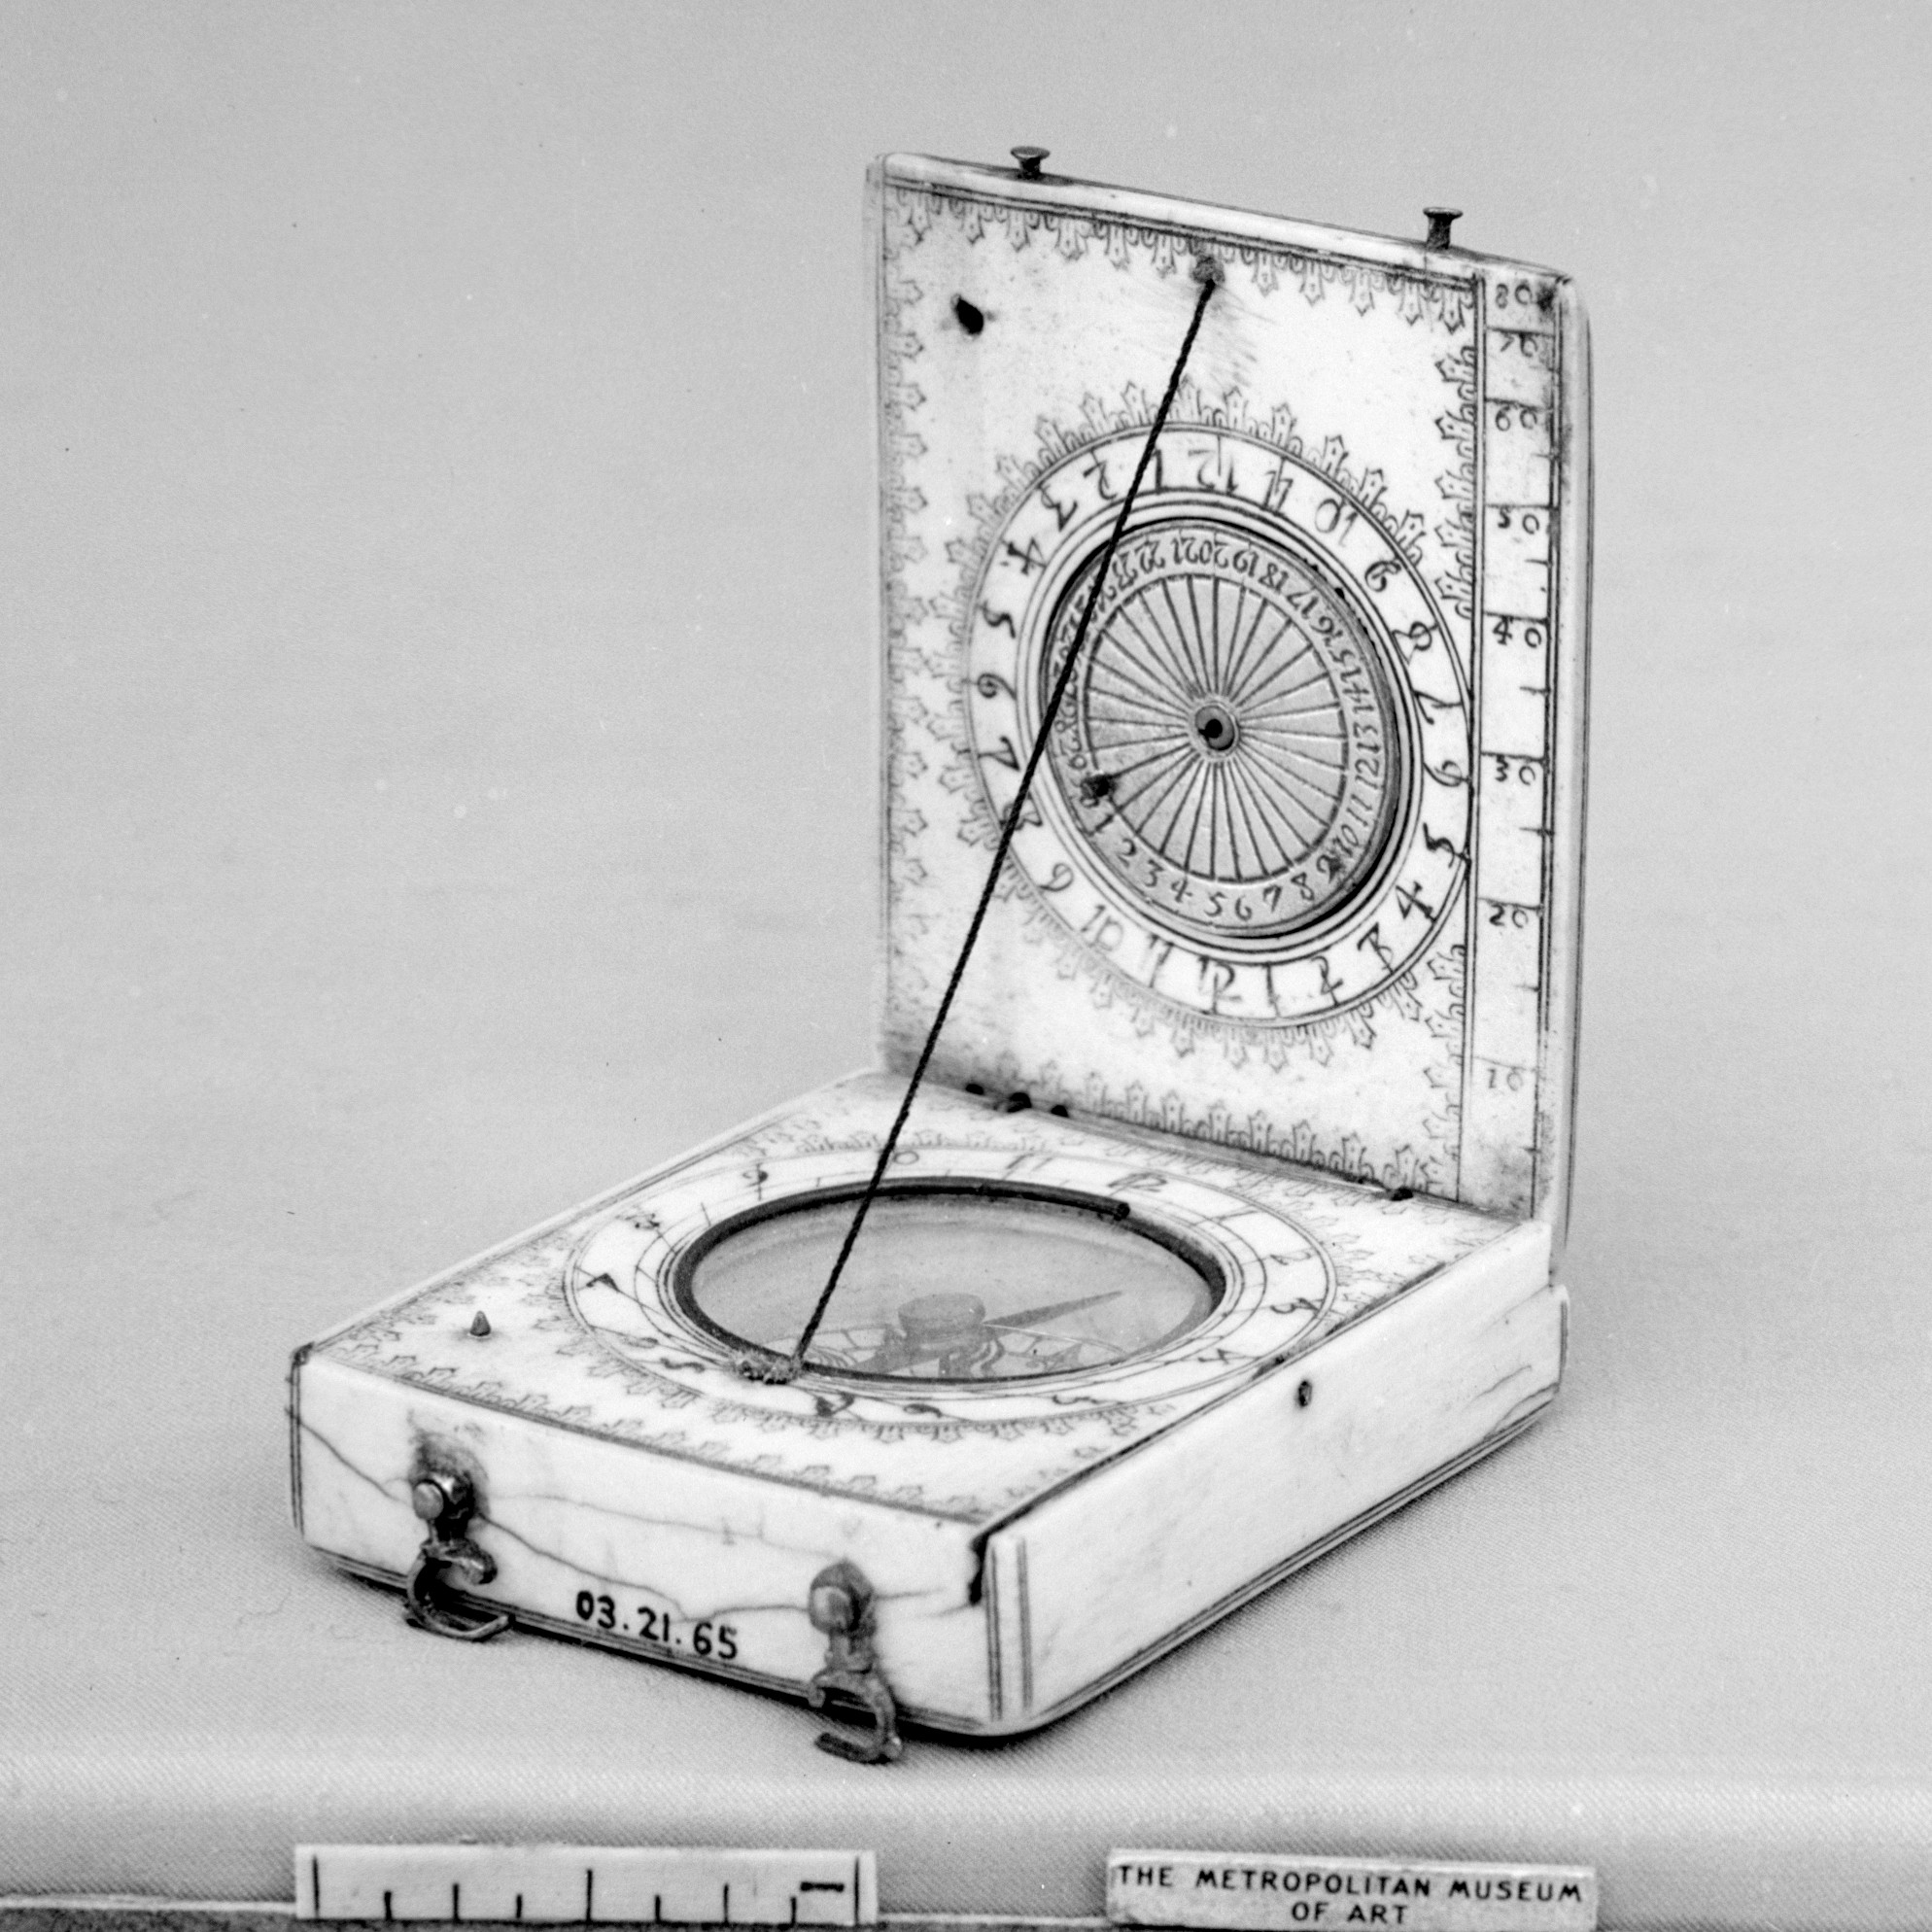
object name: portable diptych sundial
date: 1651-1700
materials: brass, ivory, pewter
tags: sundials